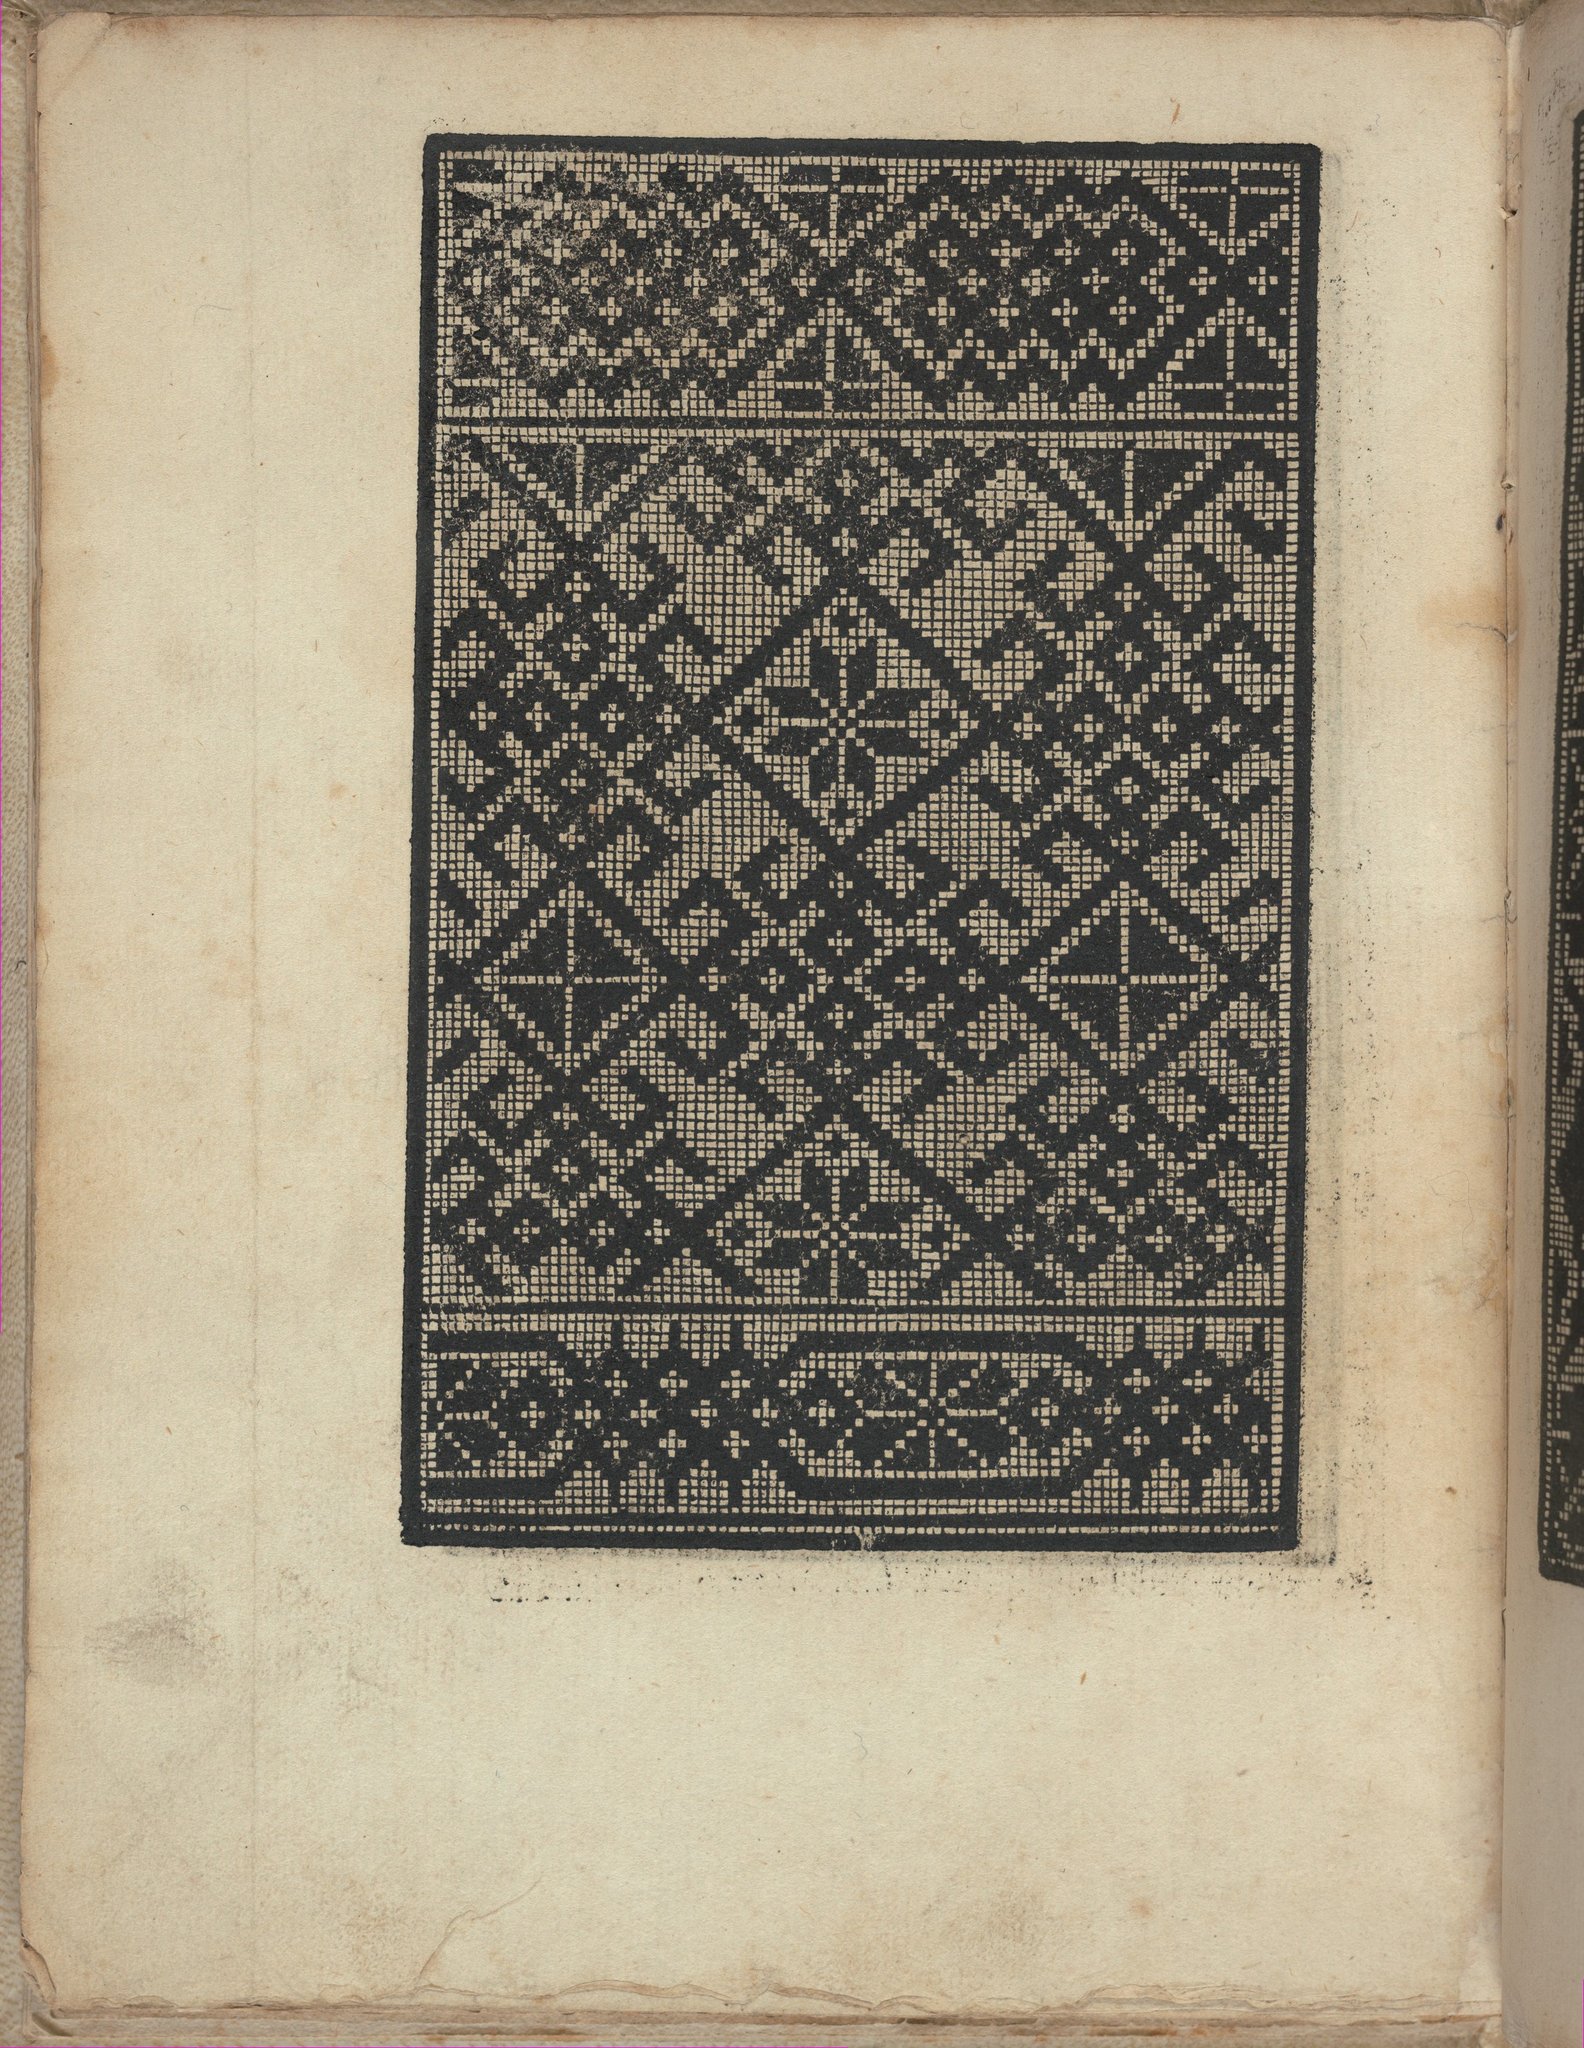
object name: book print ornament architecture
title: Esemplario di Lauori..., page 13 (verso)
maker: giovanni andrea vavassore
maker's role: publisher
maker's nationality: italian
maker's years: 1530-1573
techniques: woodcut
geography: venice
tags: ornament